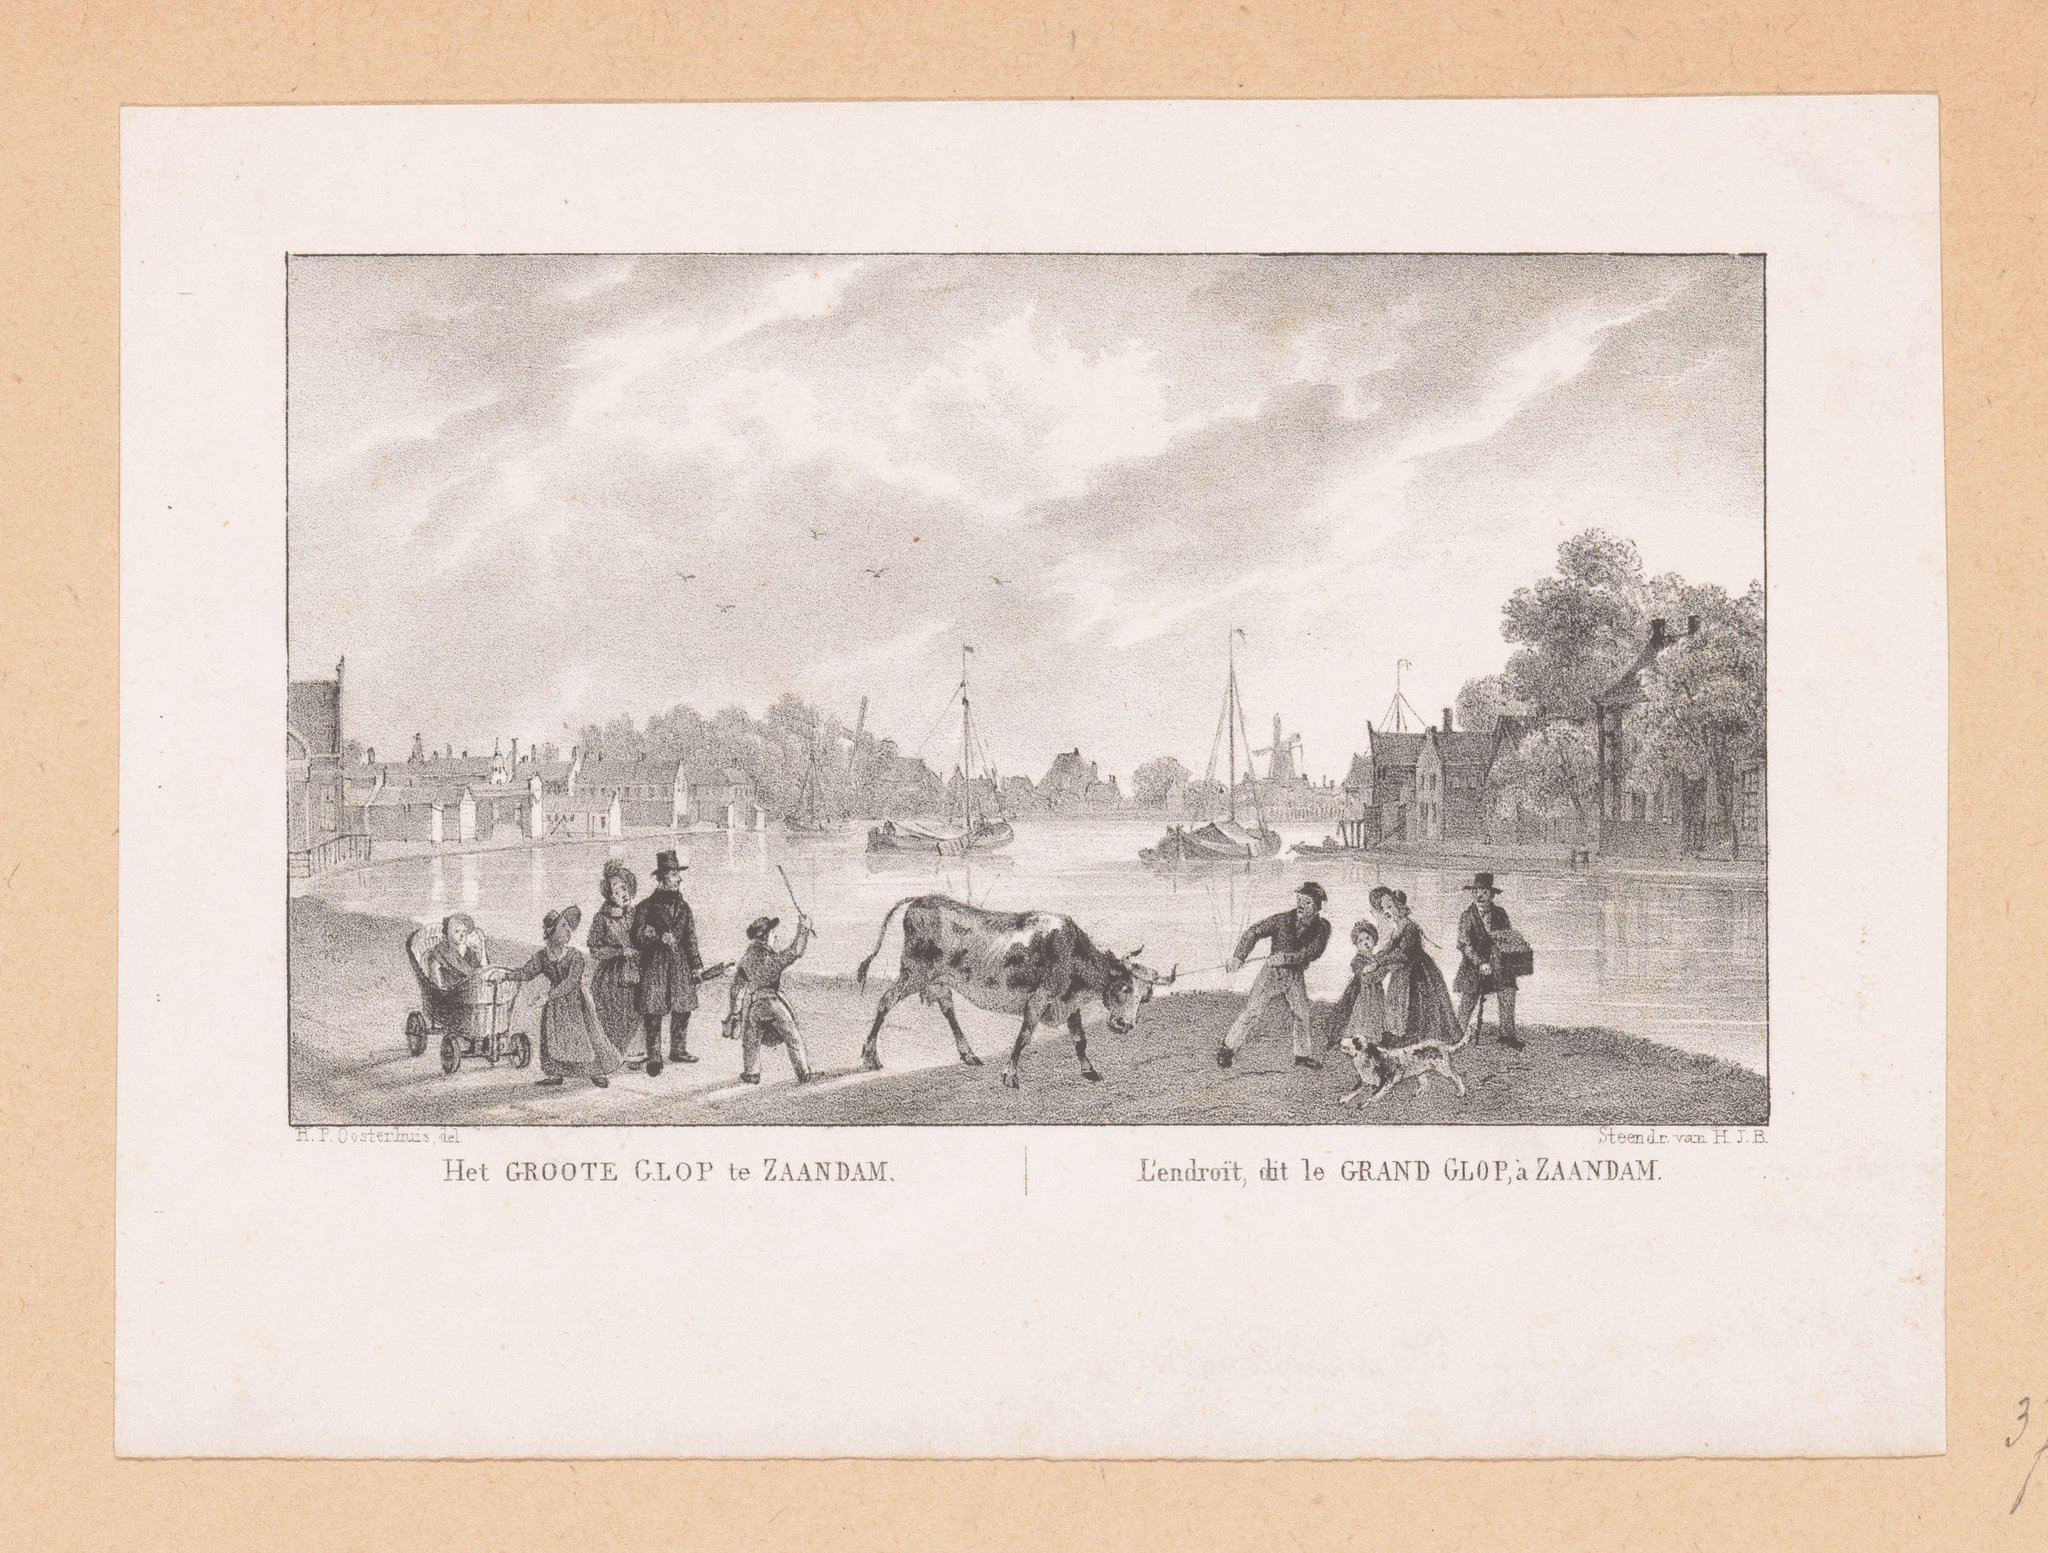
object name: print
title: Het Groote Glop te Zaandam / L'endroit, dit le Grand Glop, à Zaandam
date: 1842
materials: paper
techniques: lithograph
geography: amsterdam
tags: city-view, and landscape with man-made constructions, cow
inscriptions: collector's mark: Lugt 2228, collector's mark: Lugt 2760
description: Prent uit: Geuns, B. van. Beschrijving van Zaandam / Description de la Ville de Zaandam. Amsterdam: J.C. van Kesteren, 1842.